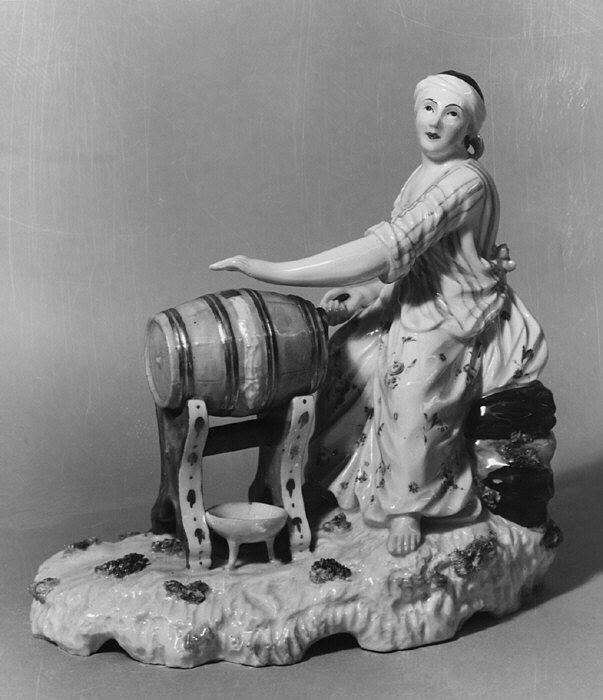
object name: figure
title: Woman making butter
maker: höchst manufactory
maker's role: manufactory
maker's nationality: german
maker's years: 1746-1796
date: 1755-1760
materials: hard paste porcelain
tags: women,working